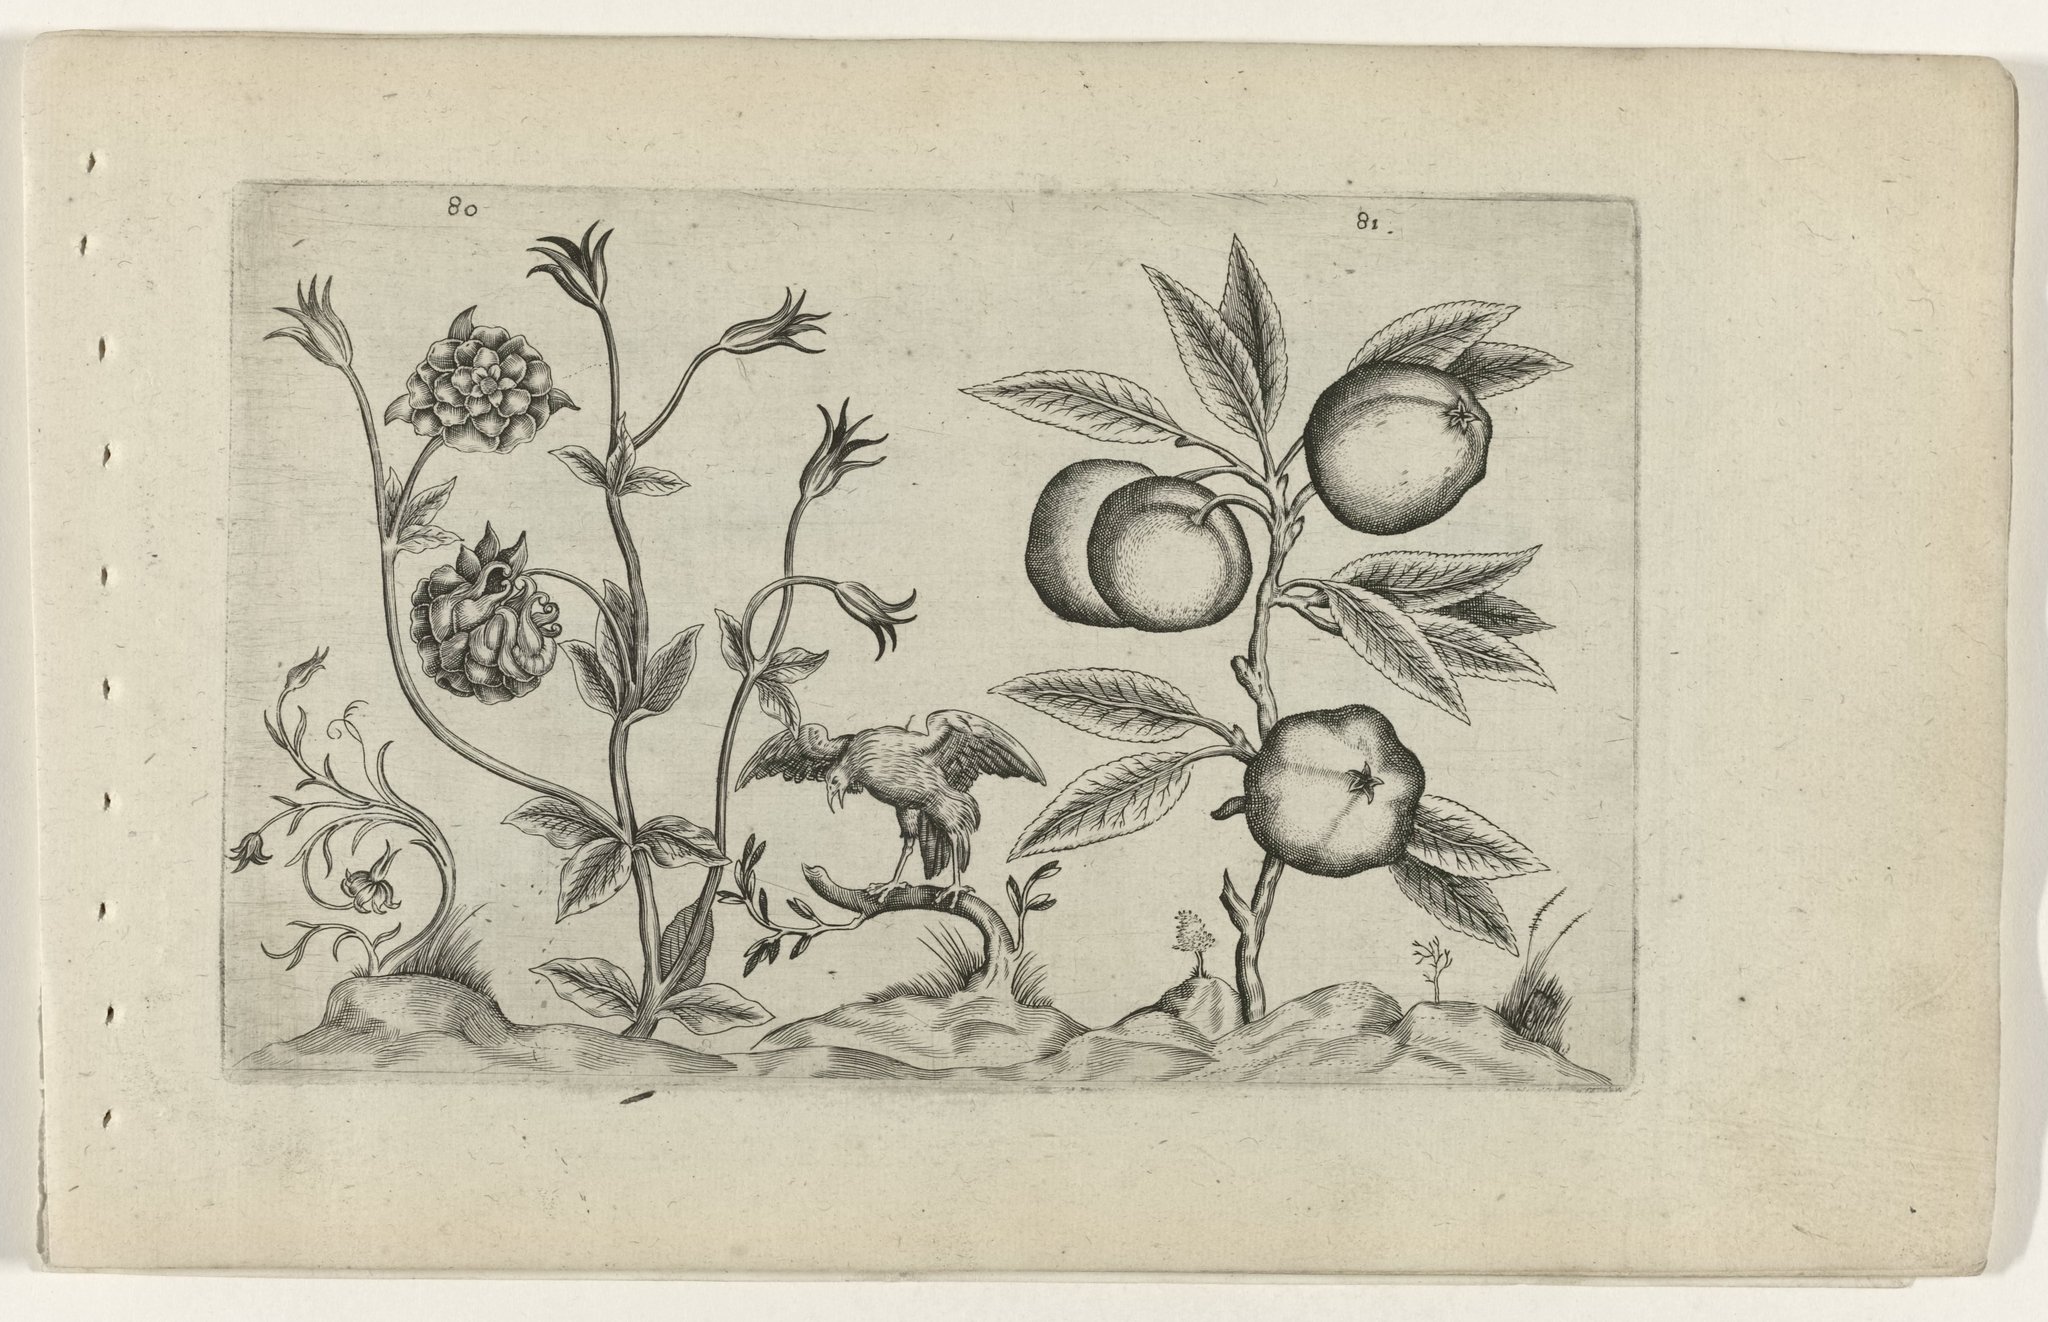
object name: album leaf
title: Dubbele akelei en appel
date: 1600-1604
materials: paper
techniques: engraving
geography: cologne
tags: fruits: apple, flowers: columbine, botany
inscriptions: collector's mark: Lugt 2228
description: De prenten RP-P-2012-24-1 t/m 61 waren oorspronkelijk als serie samengebonden. De naaigaten op de bladen zijn nog zichtbaar. Het betreft de reeks getiteld: Cognoscite lilia, bestaande uit een titelprent en 60 gravures met 119 genummerde weergaven van planten, bloemen en vruchten, versierd met rinceaux en kleine voorstellingen van dieren. Het gaat om proefdrukken van deze reeks gravures, voor de opschriften en, deels, voor de nummering. Op enkele prenten zijn de nummers met de hand aangebracht. Op de titelprent ontbreekt nog het adres van Crispijn de Passe en Hans Woutneel. De titel is hoogstwaarschijnlijk gegraveerd door Matthias Quad. Deze werkte voor De Passe in Keulen tot 1604. De reeks moet in dit jaar of daarvoor tot stand zijn gebracht. In ieder geval voor 1608, aangezien de uitgever Hans Woutneel in of voor dat jaar overleed. In ieder geval voor 1608, aangezien de uitgever Hans Woutneel in of voor dat jaar overleed. De gravures worden door Ilja Veldman en Anthony Griffiths beschouwd als eigenhandig werk van Crispijn de Passe I. Een van de prenten uit de reeks ontbreekt (nr 21-22) en is vervangen door een ingekleurde afdruk uit een latere uitgave (RP-P-2012-24-61), die onder de titel Altera Pars is opgenomen in de Hortus Floridus, uitgegeven door Crispijn de Passe I en die verder bestaat uit platen van Crispijn de Passe II. De prenten afkomstig uit deze uitgave zijn op de verso voorzien van tekst in boekdruk. De vervangende prent maakte geen deel uit van de gebonden serie aangezien dit blad als enige geen naaigaten heeft. Een deel van de planten, bloemen en vruchten in de Cognoscite lilia gaat terug of is gebaseerd op een reeks aquarellen van Jacques LeMoyne uit circa 1580 en uit 1585, nu in het Victoria and Albert Museum en de British Museum (zie P. Hulton, Jacques LeMoyne, Londen 1977, dl 1, p. 156-162 en p. 165-173).